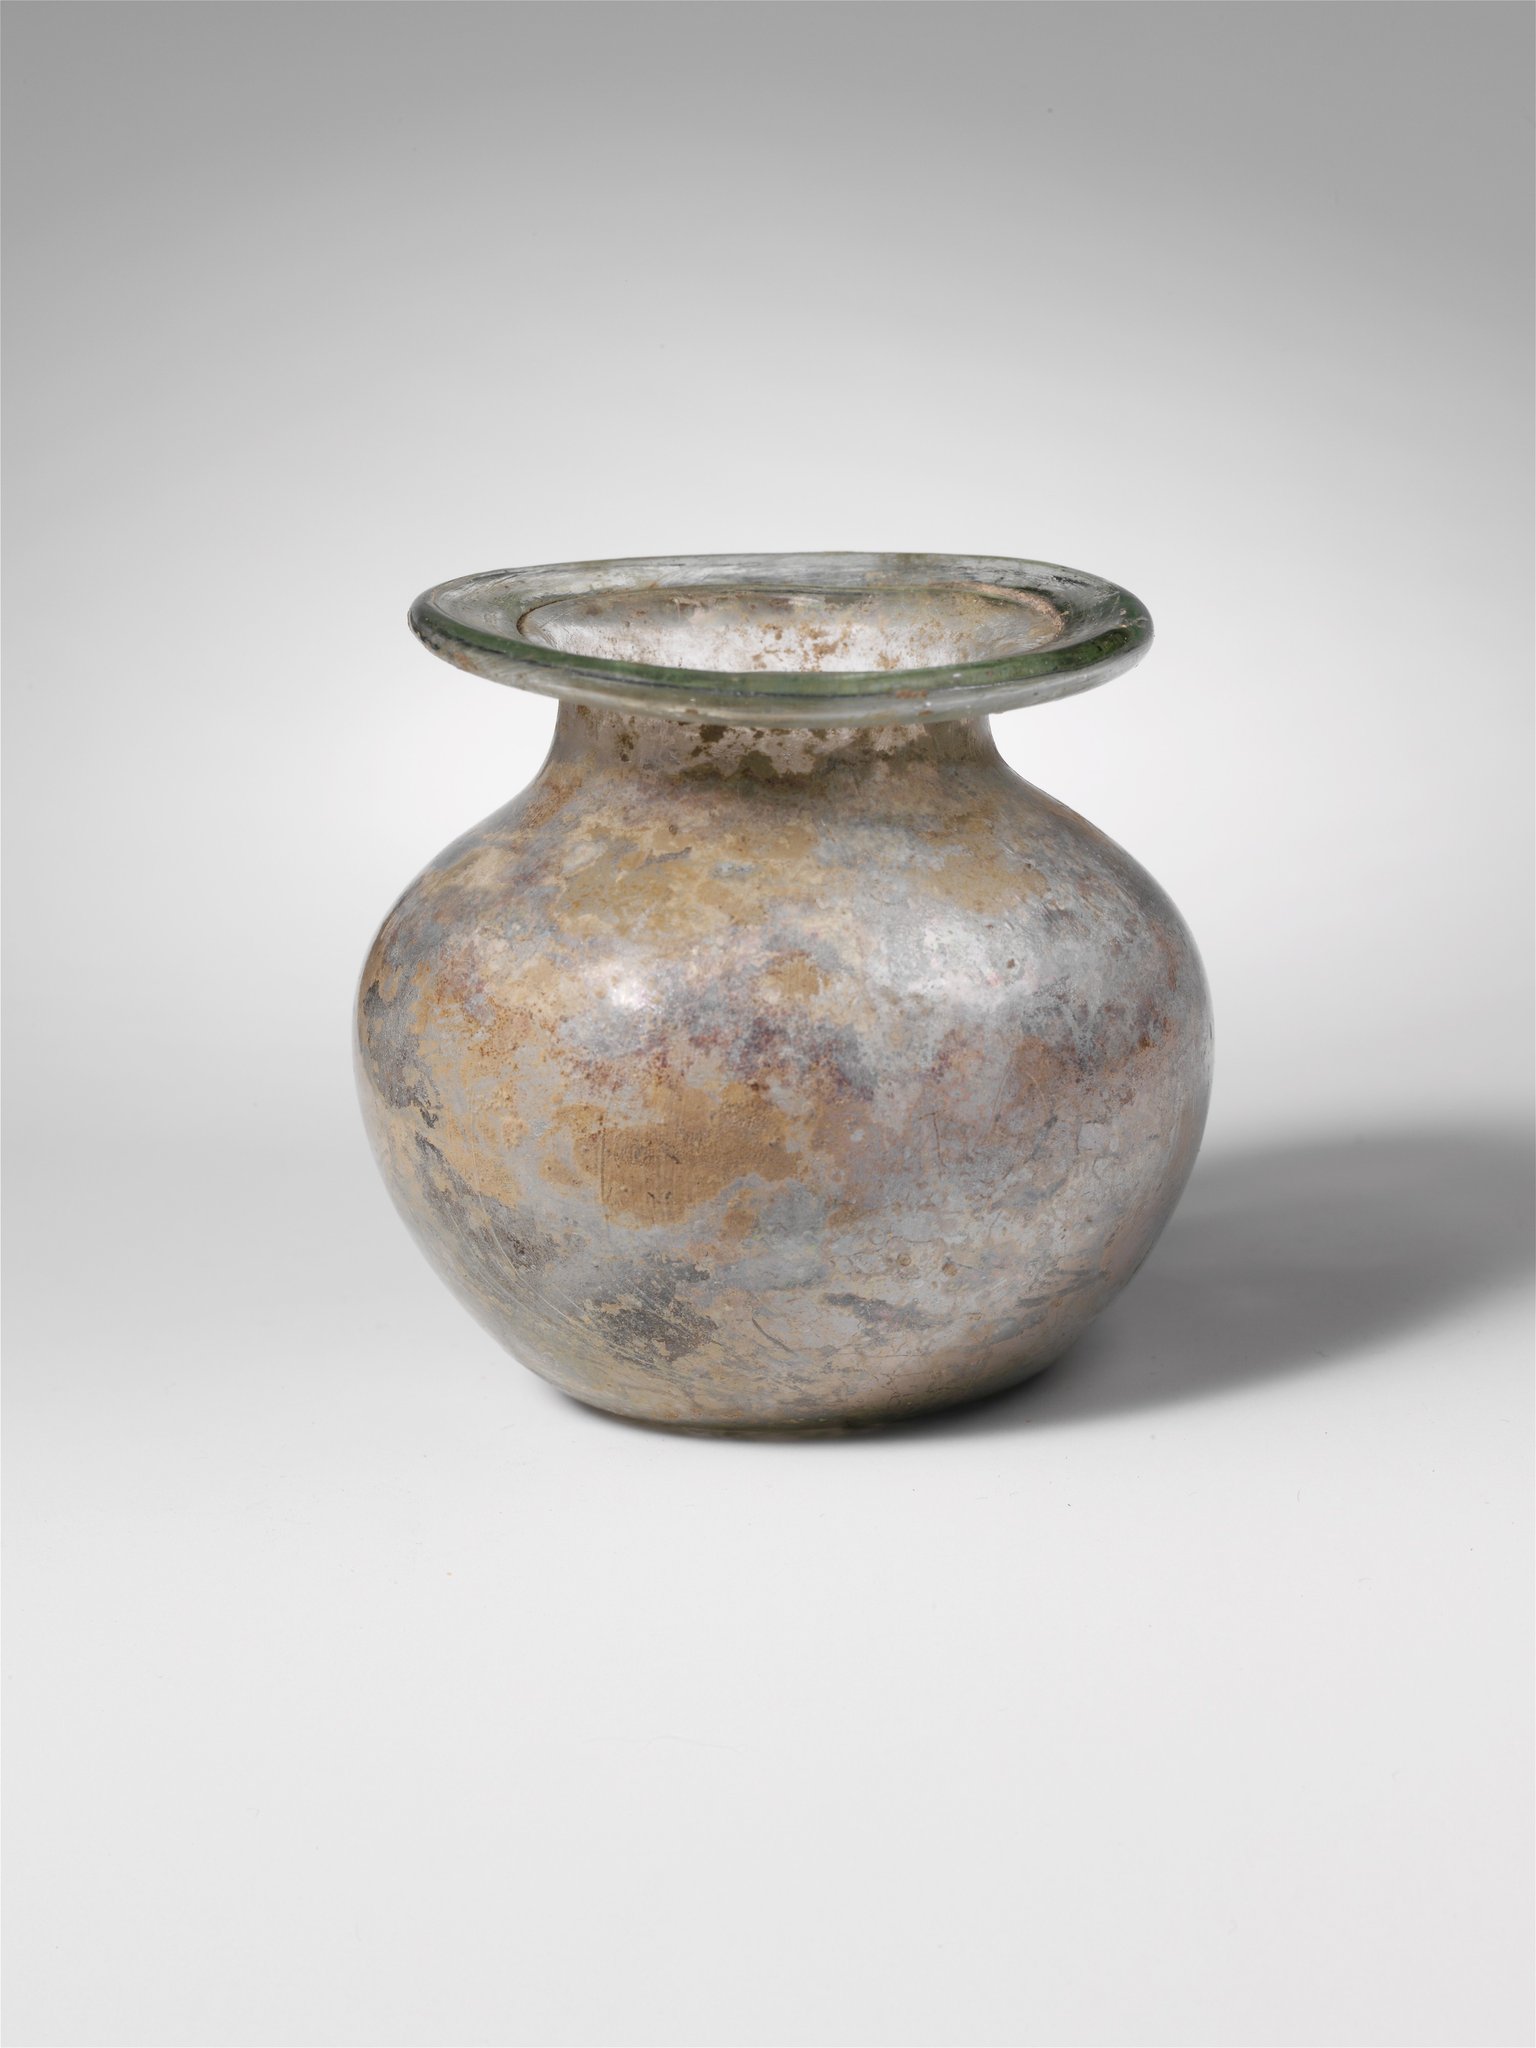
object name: jar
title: Glass jar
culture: roman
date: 101-300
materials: glass